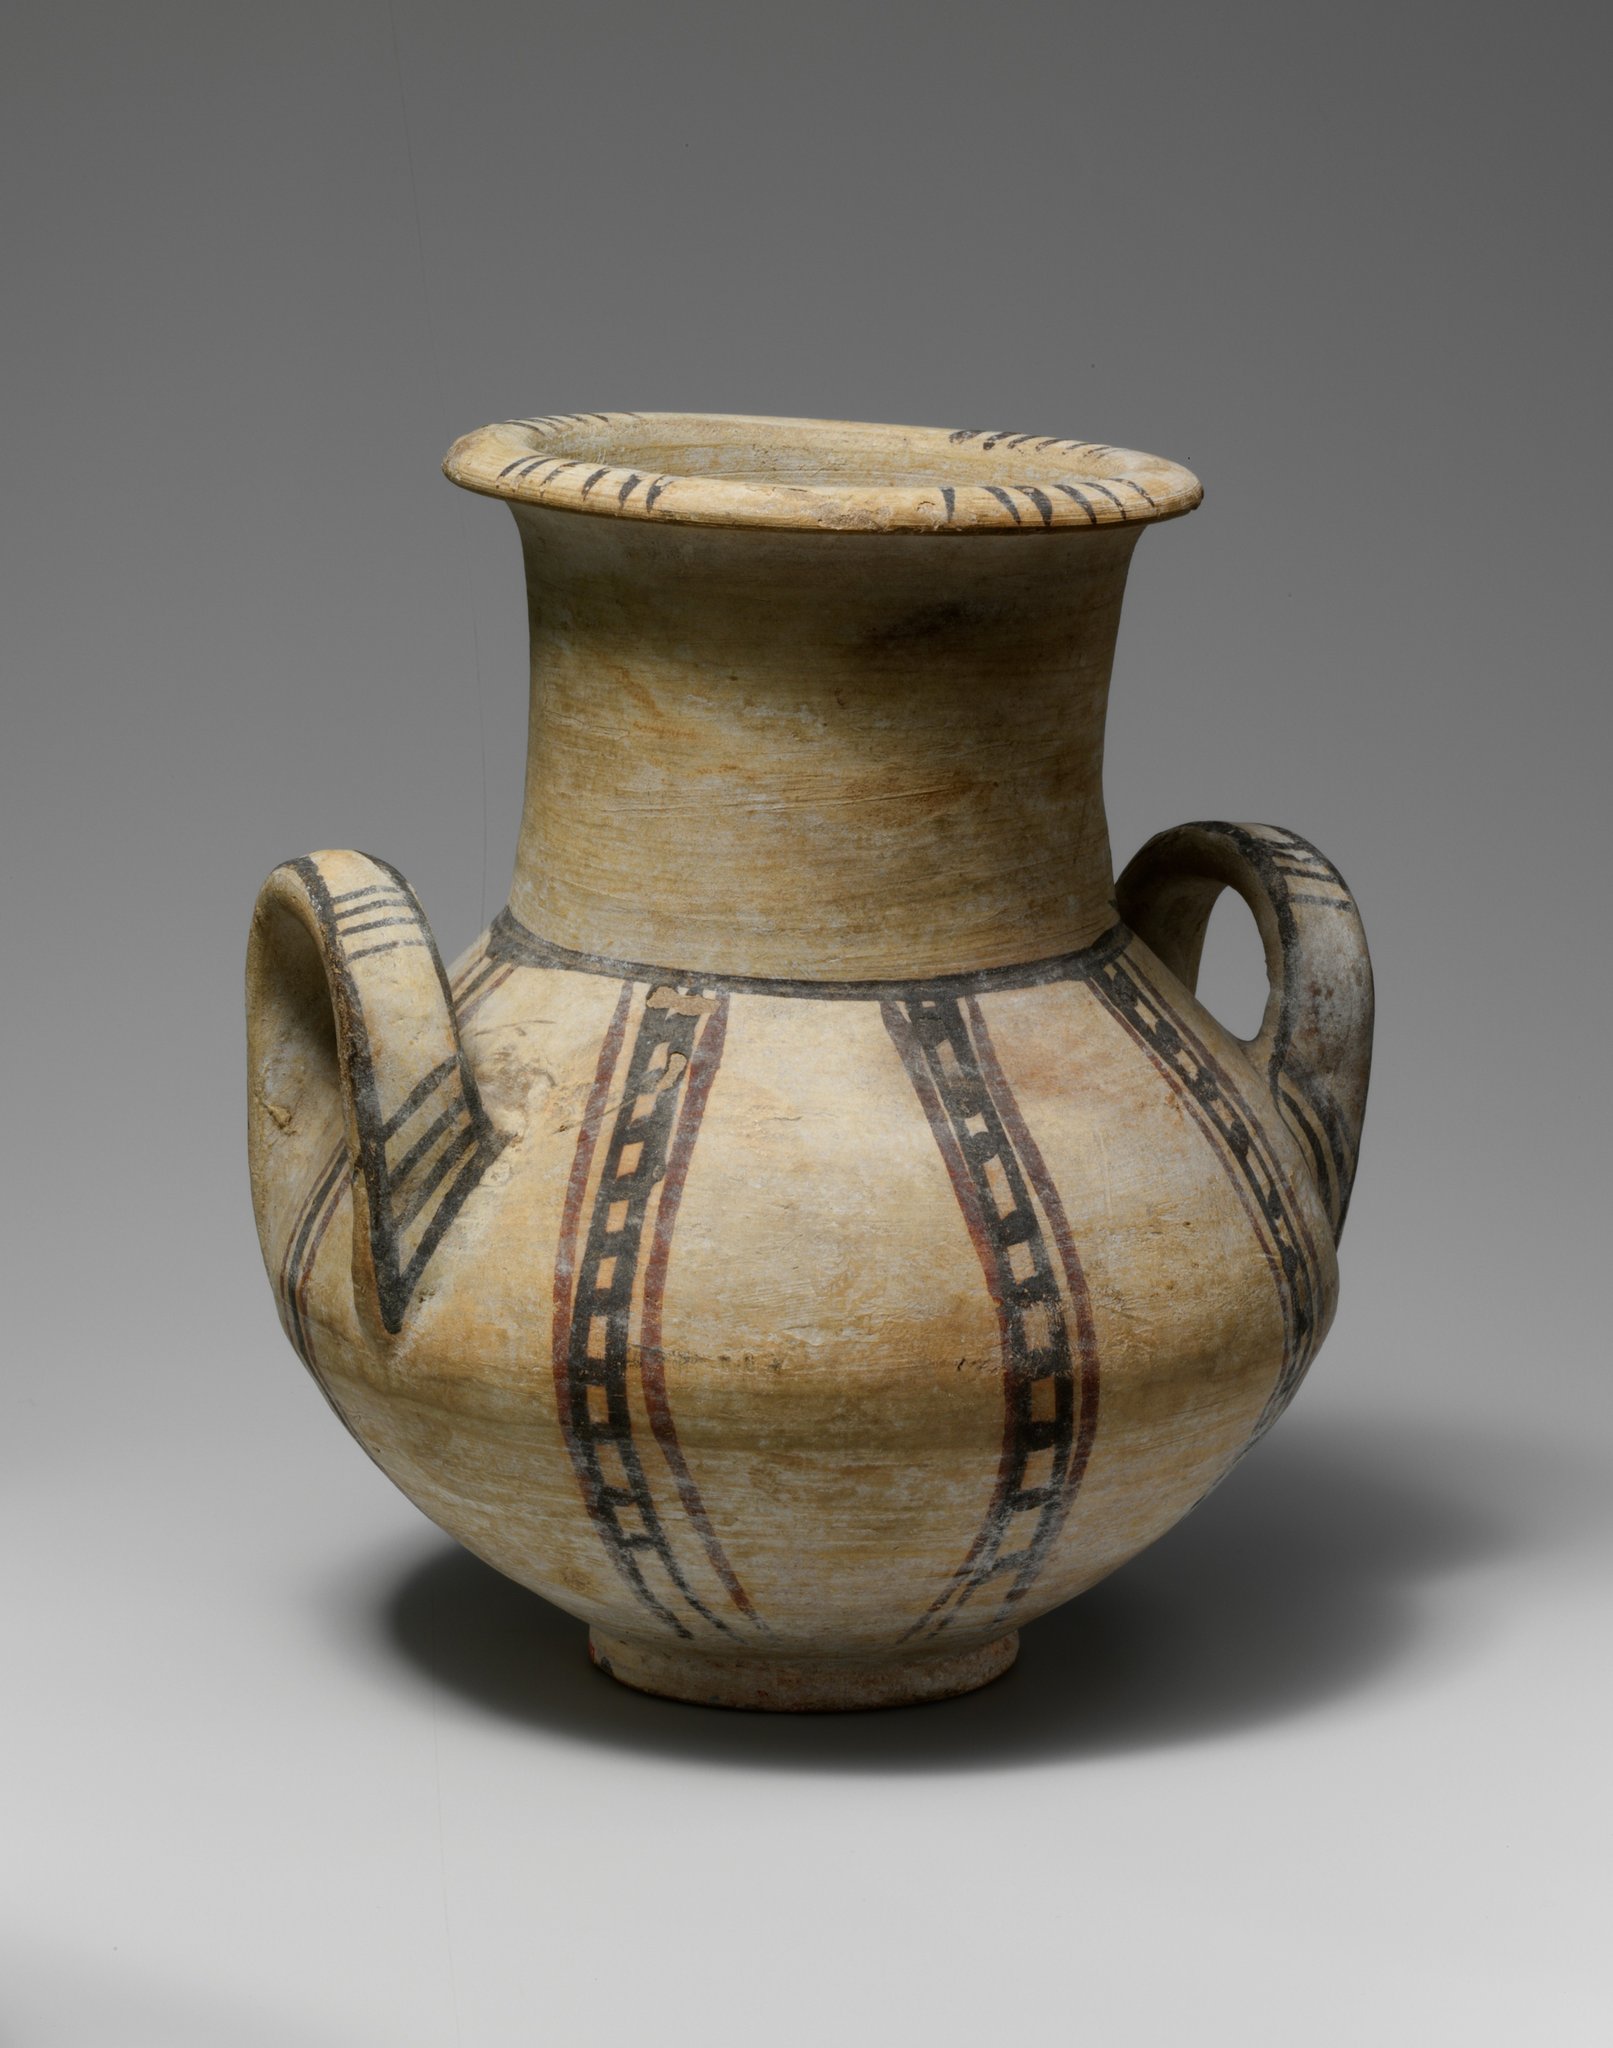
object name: jar, painted, two handle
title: Two-handled Jar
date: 1550-1458 BCE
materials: pottery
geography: egypt